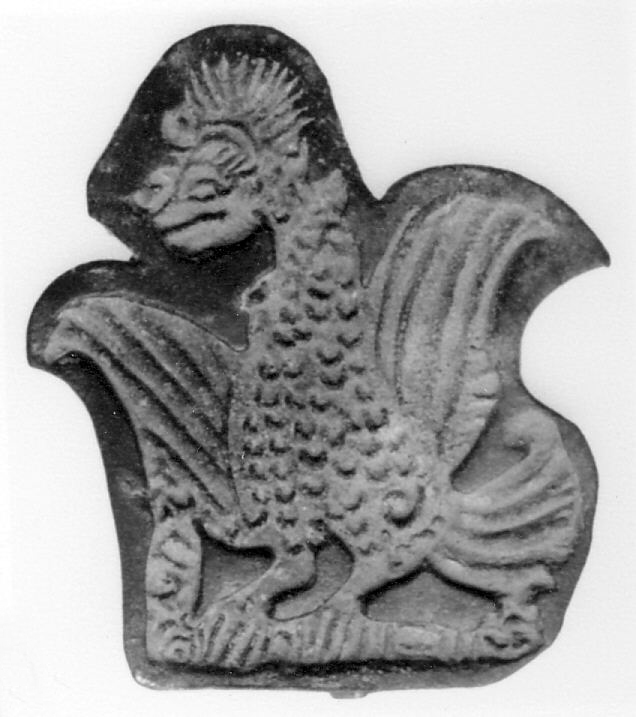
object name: mold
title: Mold (Bird-Shaped)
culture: indonesian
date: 901-1100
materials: bronze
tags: birds